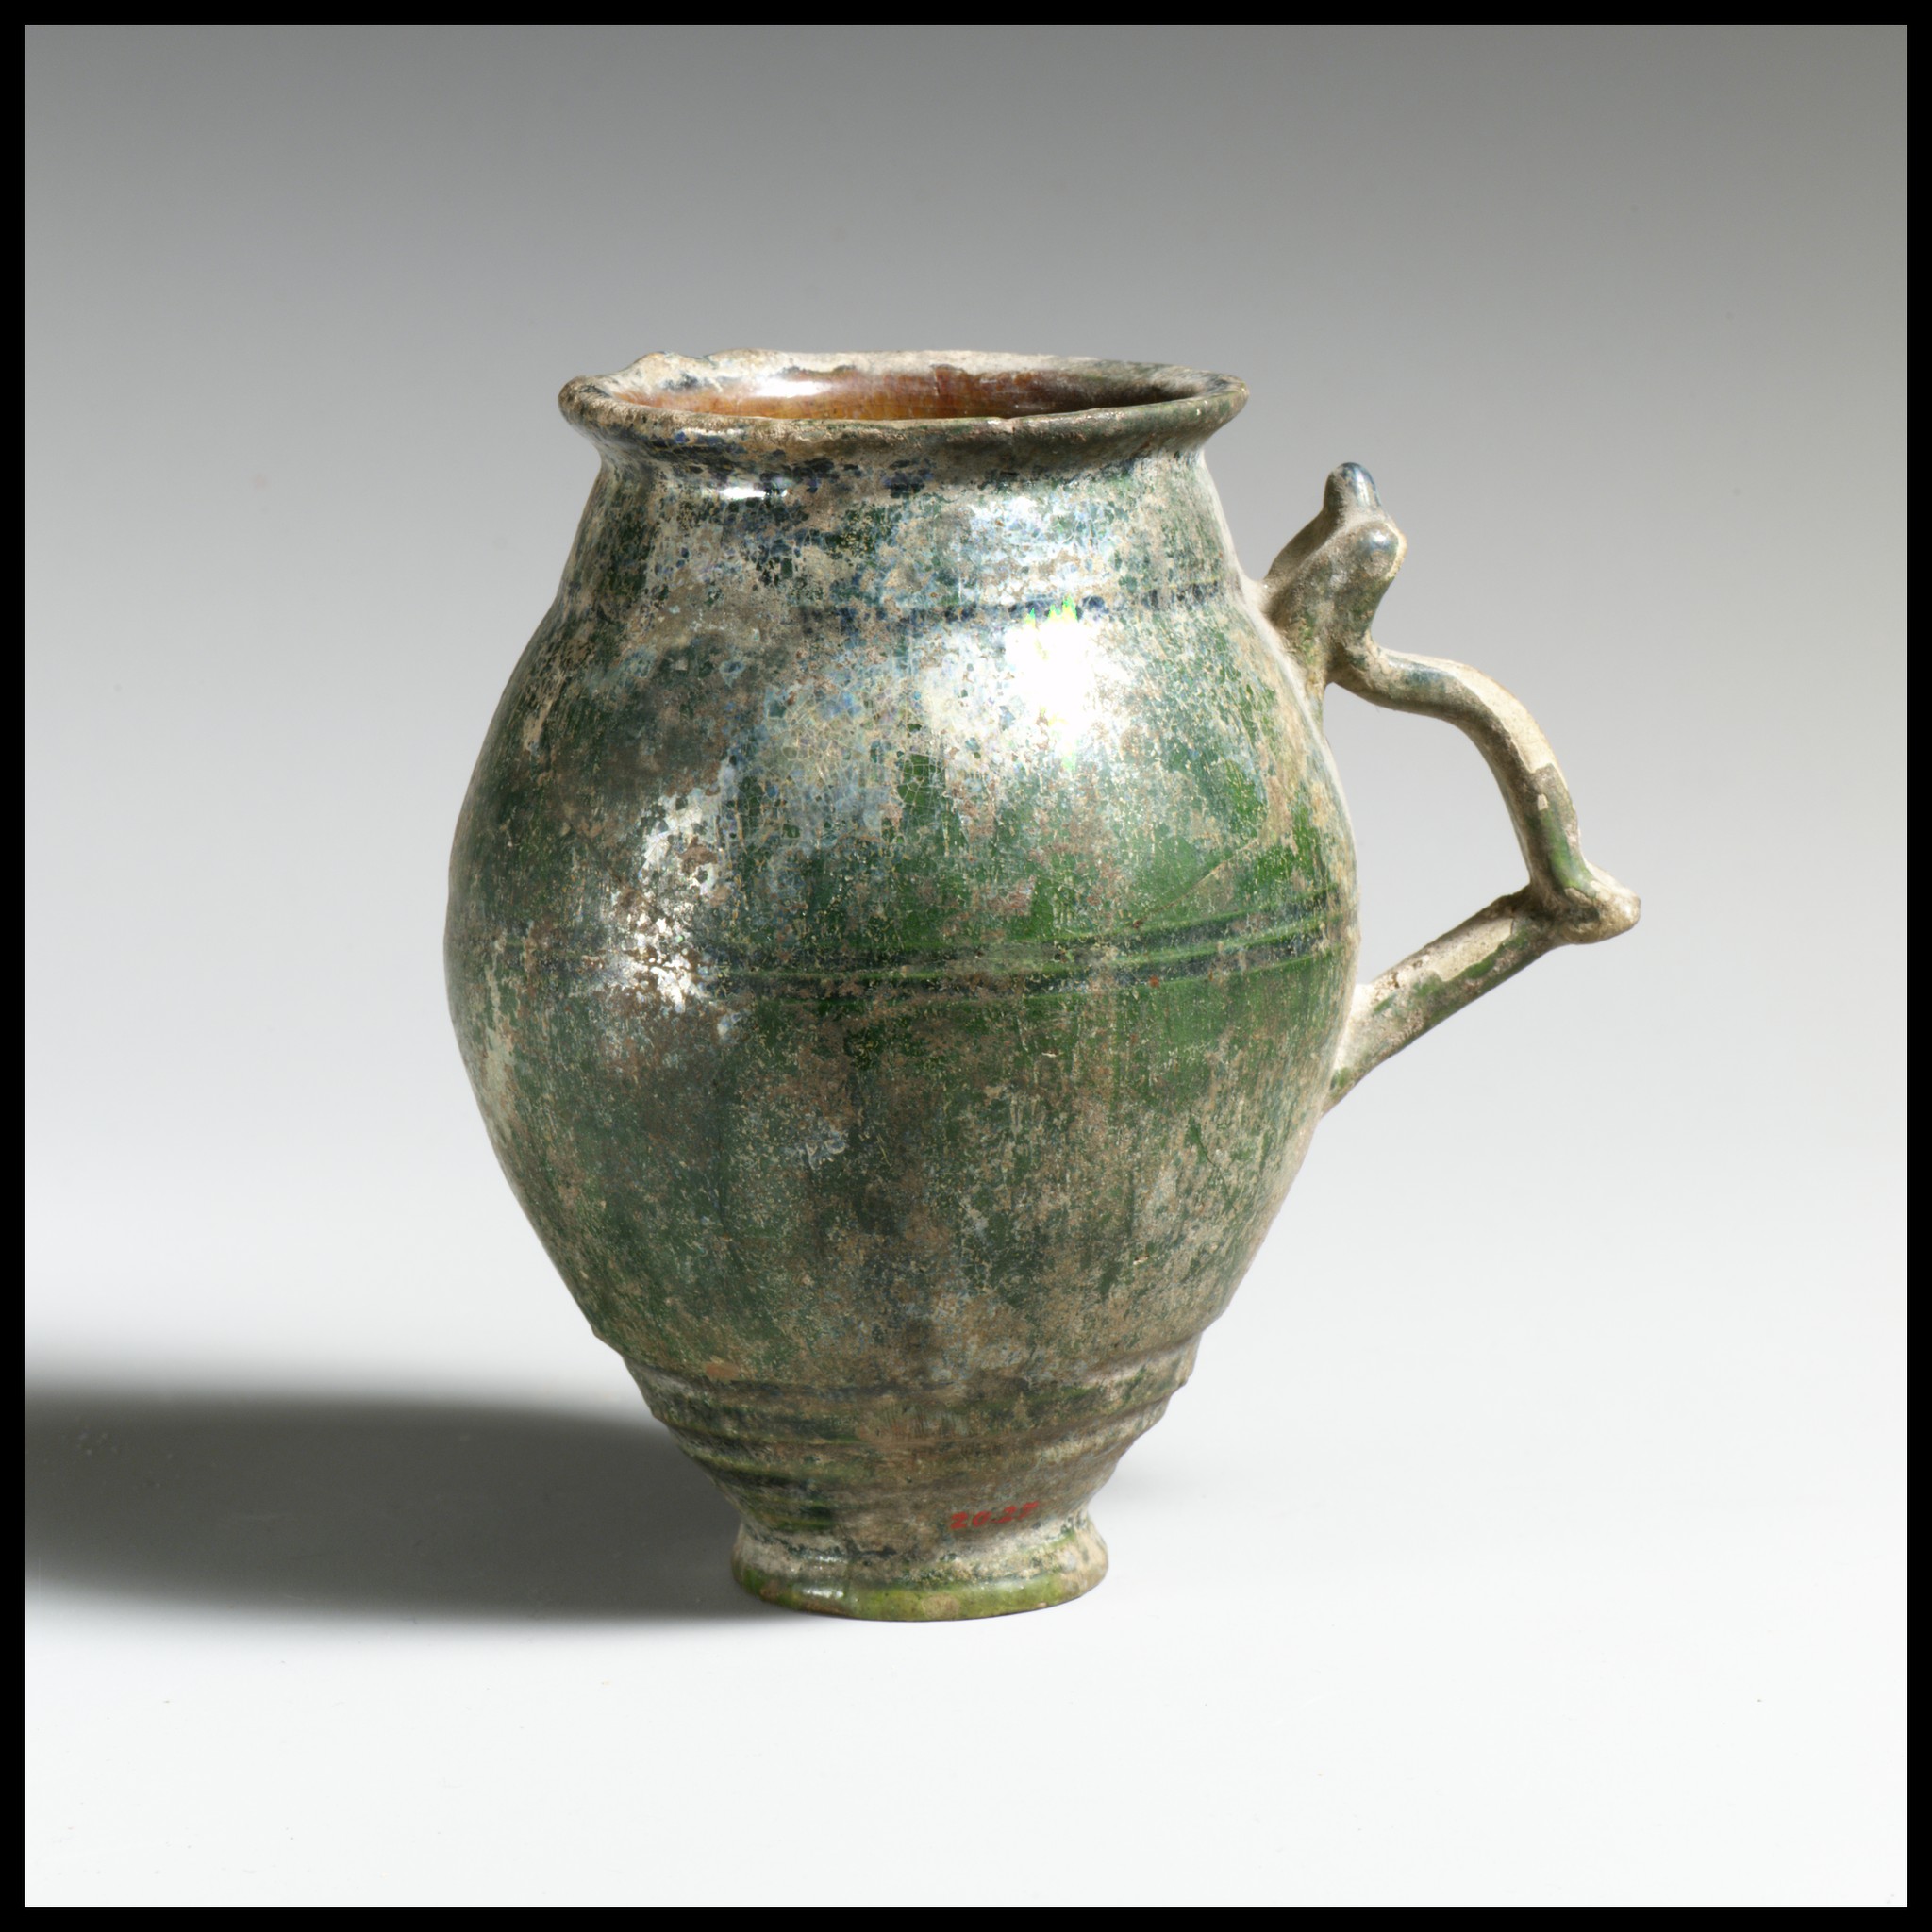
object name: cup, one handled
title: Terracotta one-handled cup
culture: roman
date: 67-100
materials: terracotta